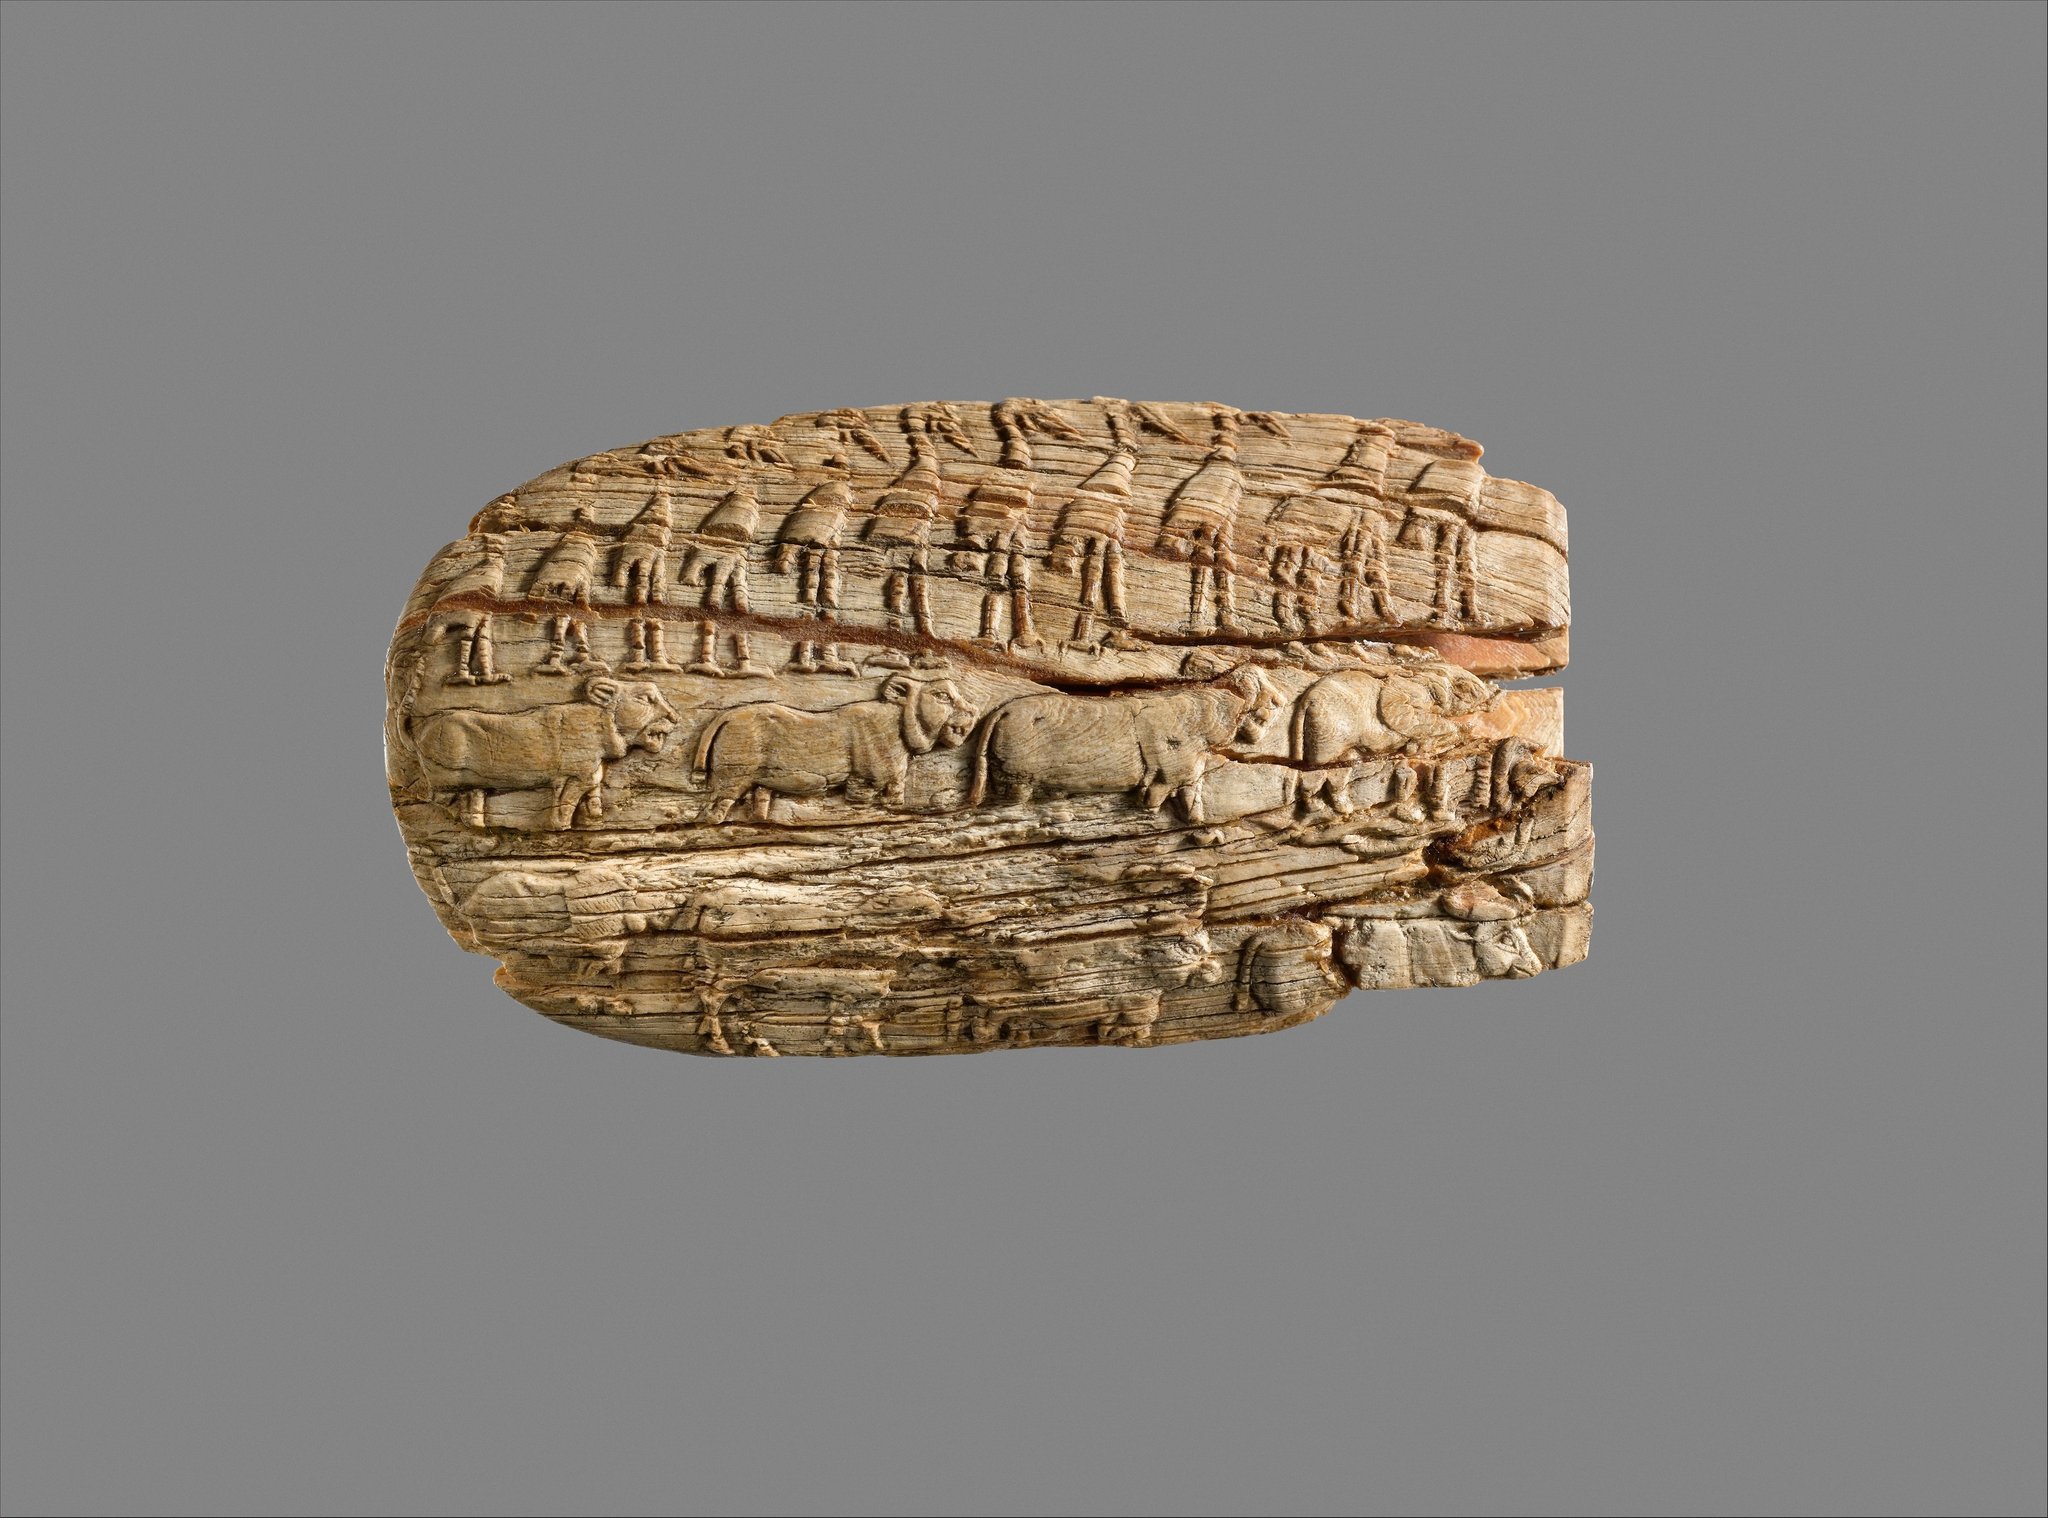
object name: knife handle, carved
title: Carved handle of a ceremonial knife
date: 3200 BCE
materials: ivory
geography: upper egypt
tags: birds,elephants,lions